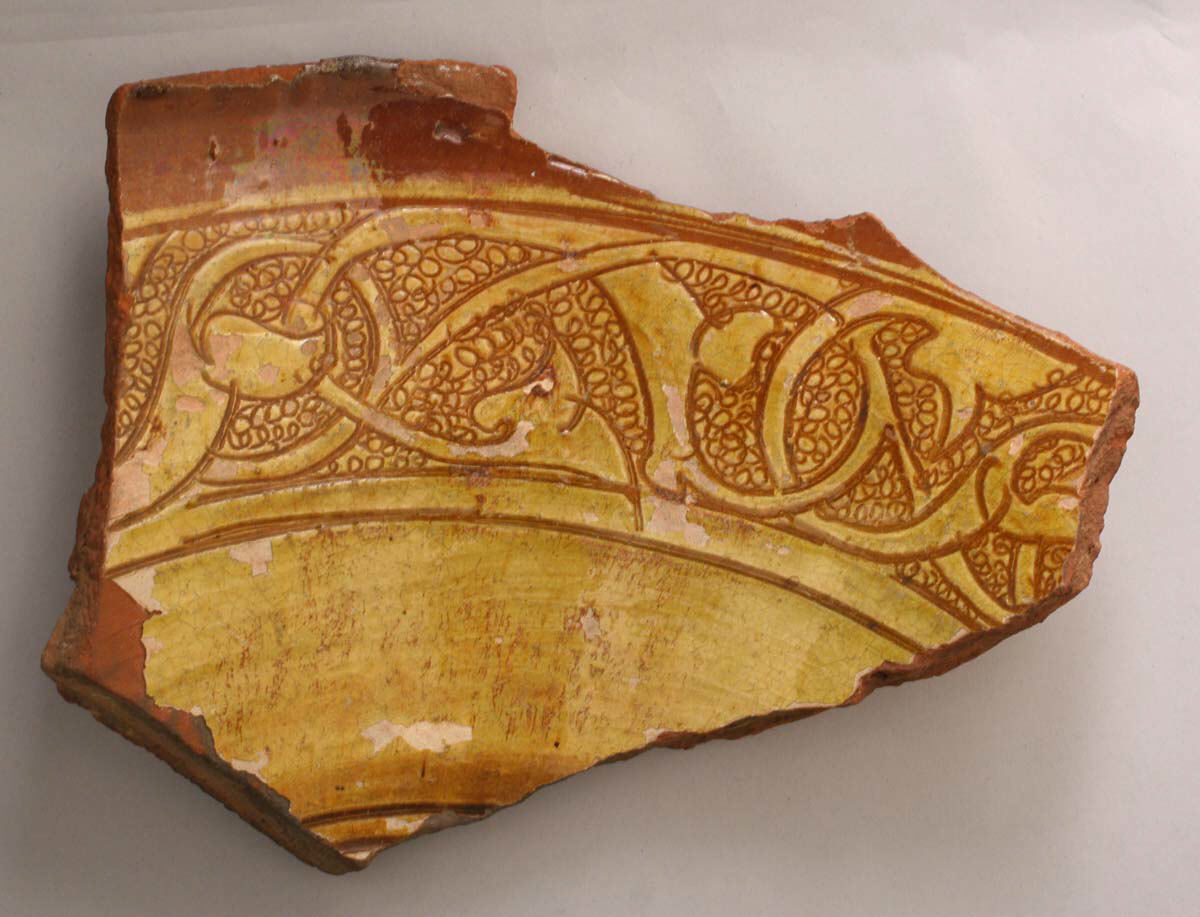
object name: fragment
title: Fragment of a Dish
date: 1301-1500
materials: earthenware, glaze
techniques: coloring, incising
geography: egypt